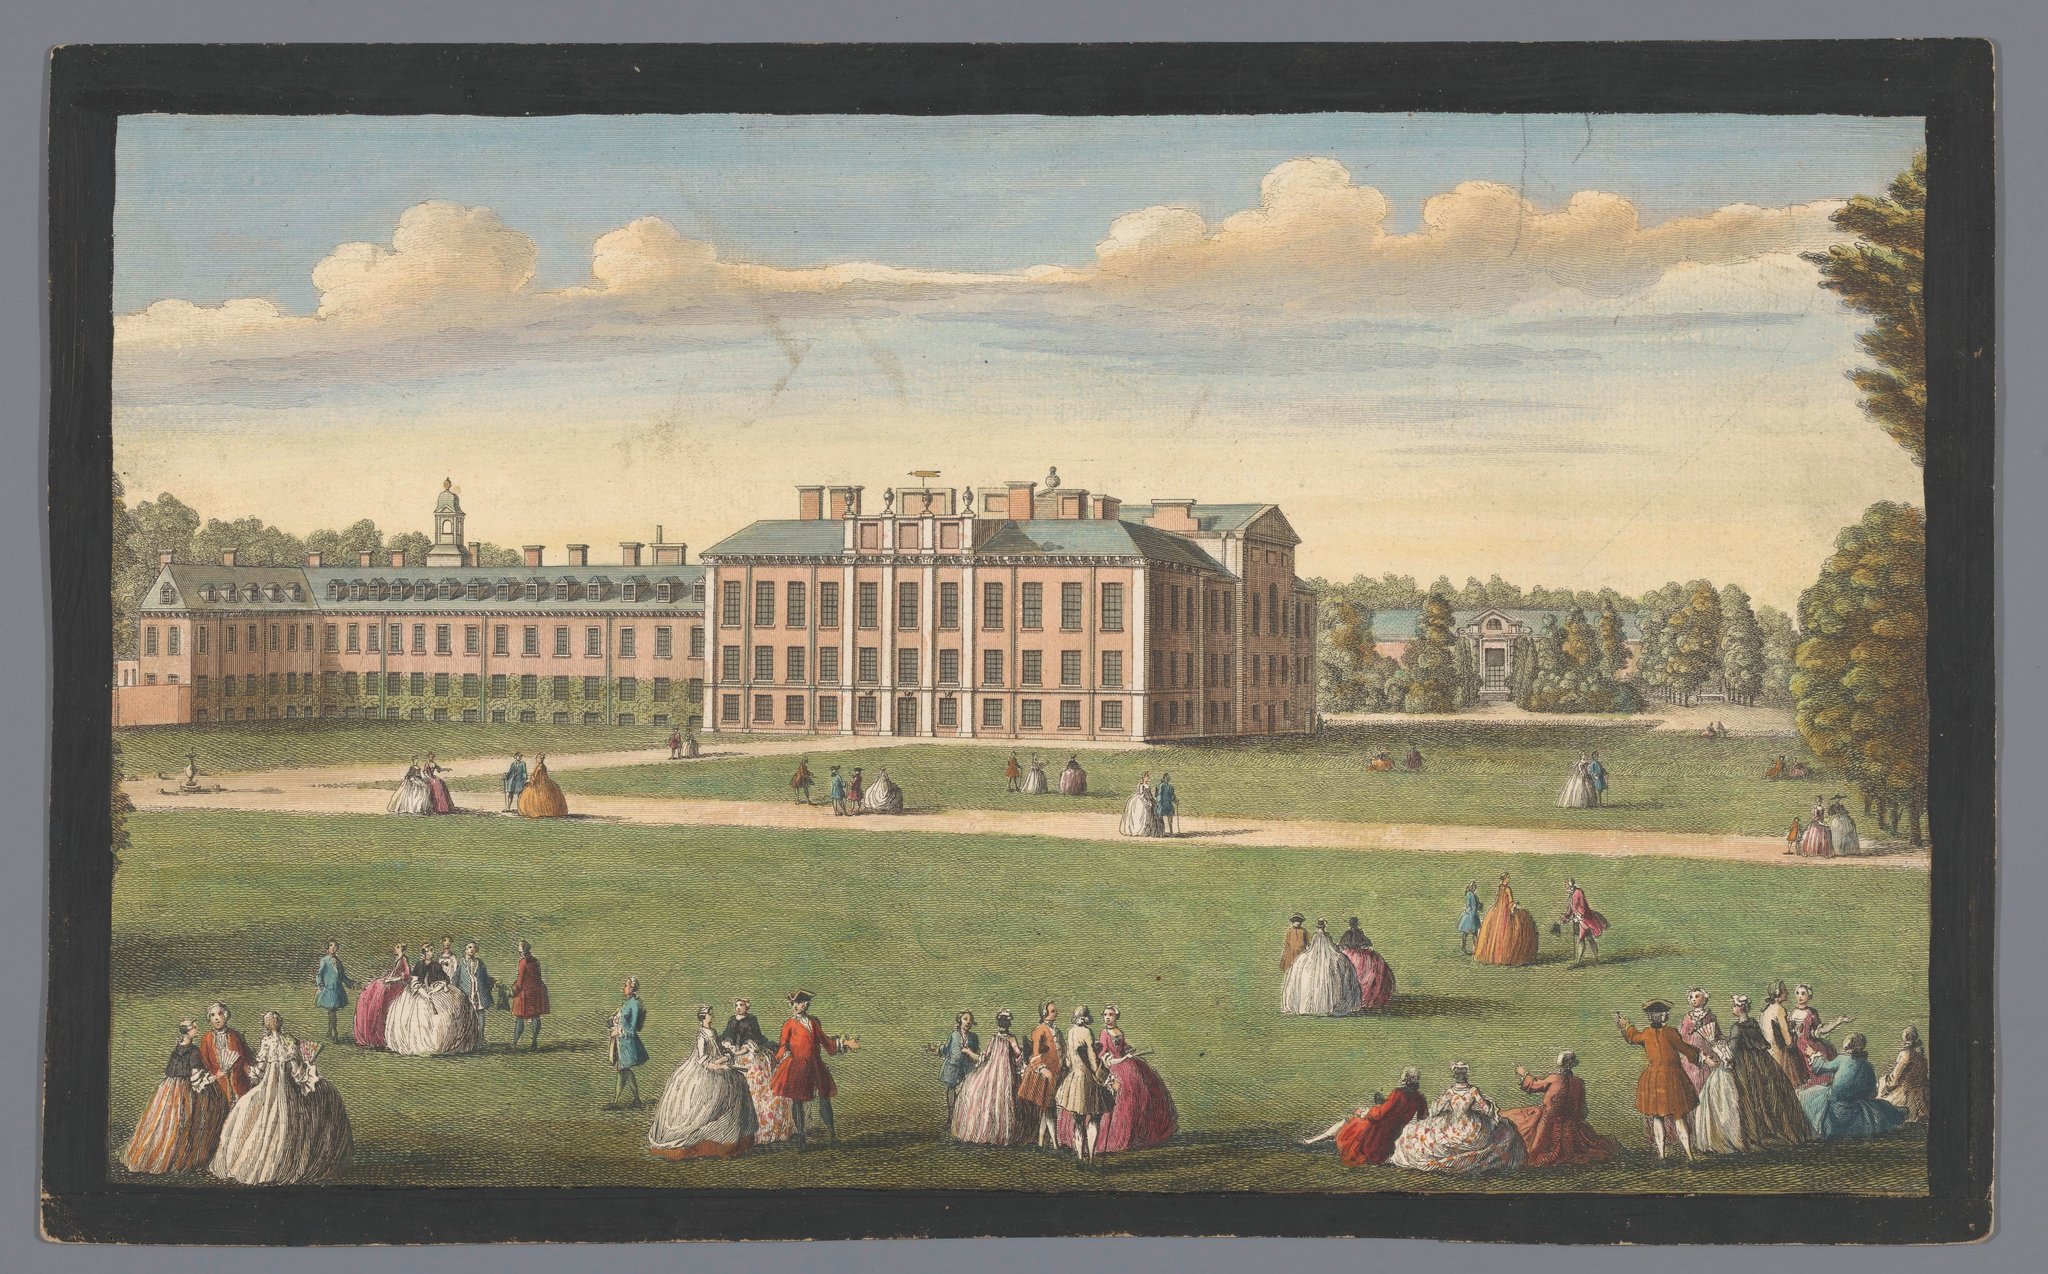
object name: print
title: Gezicht op Kensington Palace te Londen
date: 1751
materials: cardboard, paper, watercolor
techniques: brush, etching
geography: england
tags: palace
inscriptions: collector's mark: Lugt 2233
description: De serie “Londen” bevat 52 prenten met de nummers 1-52, waarvan dit nummer 51 is.